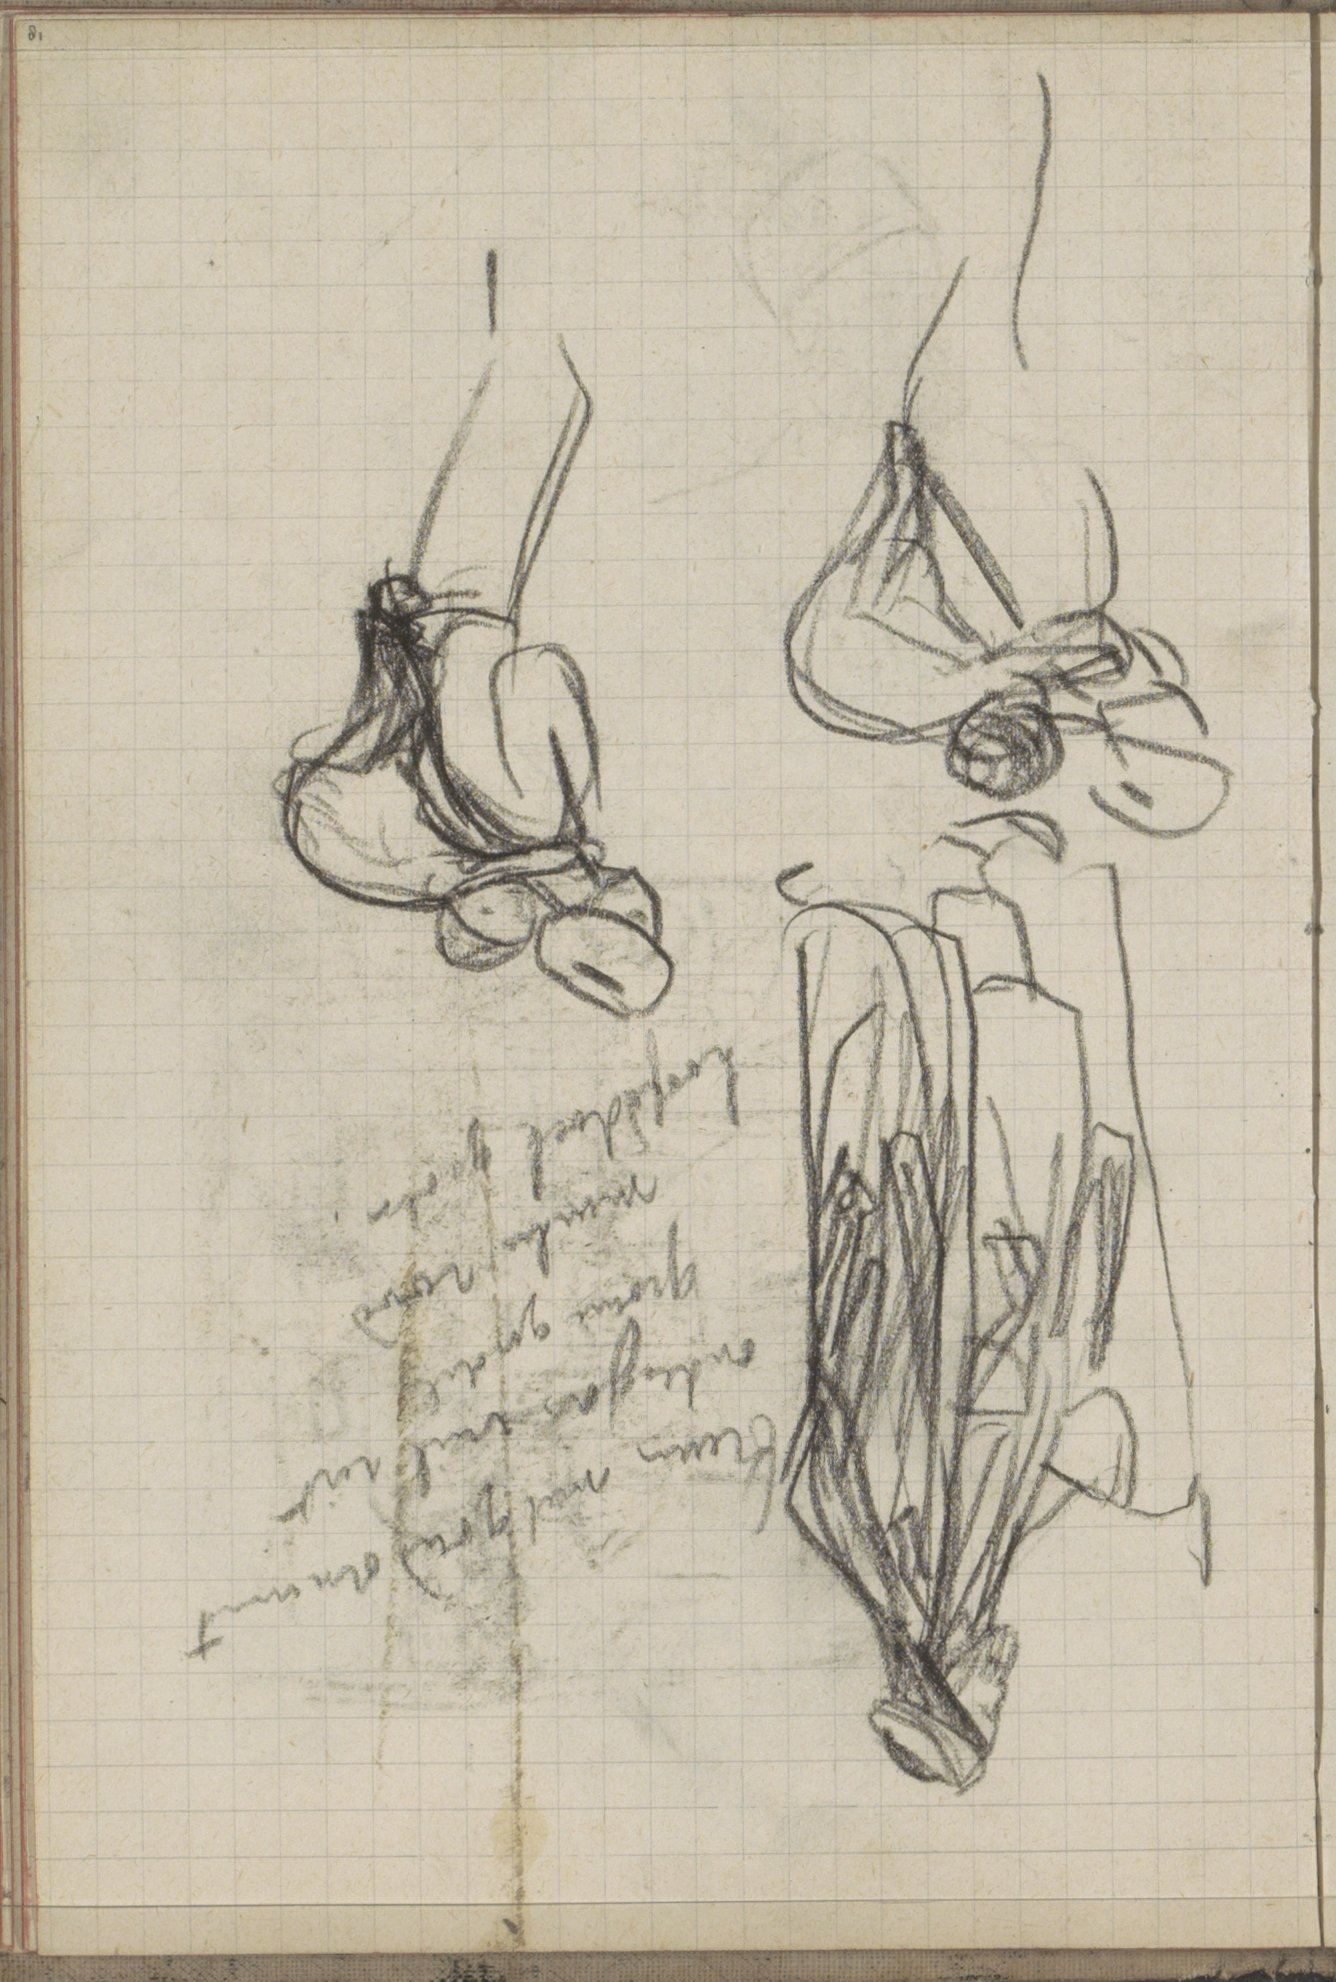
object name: sketchbook leaf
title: Figuur met een kind op de rug en man met staf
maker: marius bauer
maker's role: draughtsman, print maker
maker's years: 1867-1932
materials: chalk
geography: istanbul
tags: asiatic races and peoples, walking-stick, staff, adult man, child, carrying a child on the back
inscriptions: kleurnotitie, handgeschreven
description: De figuren dragen oosterse kleding en hoofddeksels. Pagina 81 uit een schetsboek met 54 bladen.